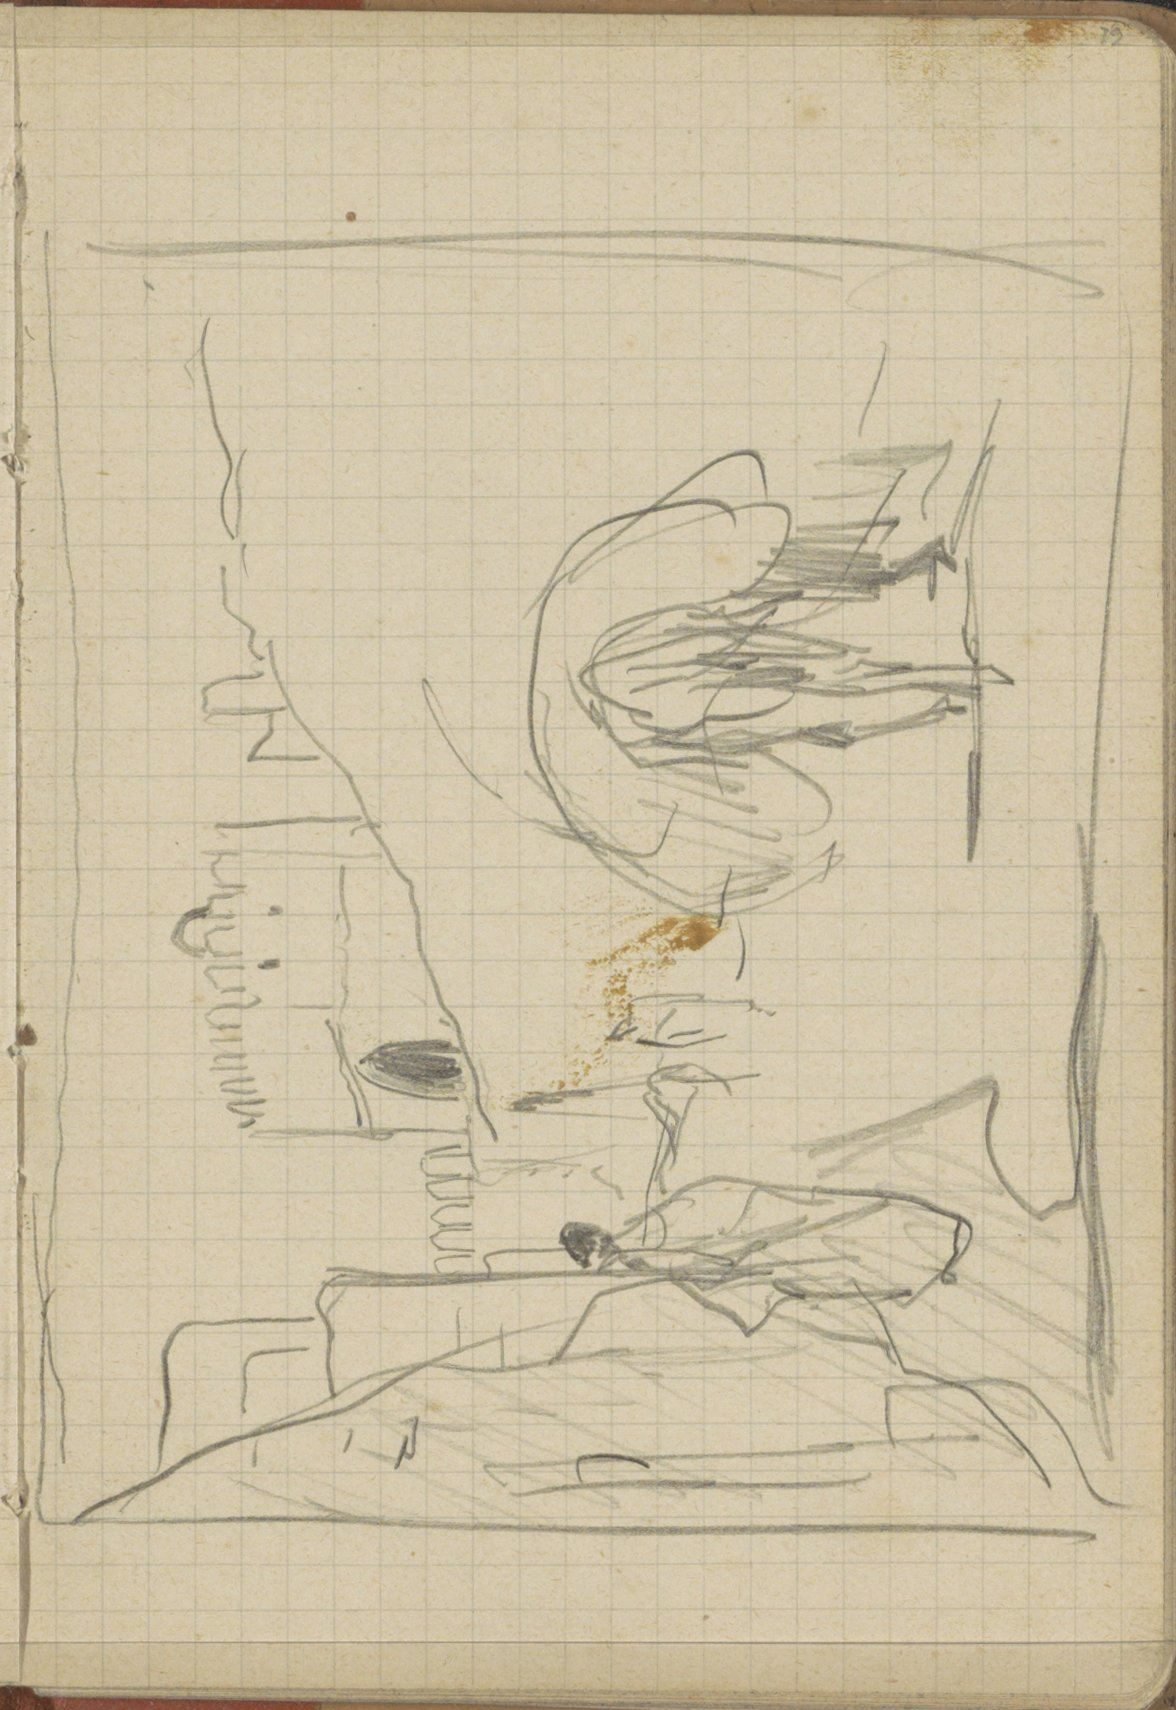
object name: sketchbook leaf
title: Straat met een pakezel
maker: marius bauer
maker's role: draughtsman, print maker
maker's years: 1867-1932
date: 1909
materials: pencil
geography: tunisia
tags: ass, donkey, street (+ city(-scape) with figures, staffage)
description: Pagina 79 uit een schetsboek met 67 bladen.